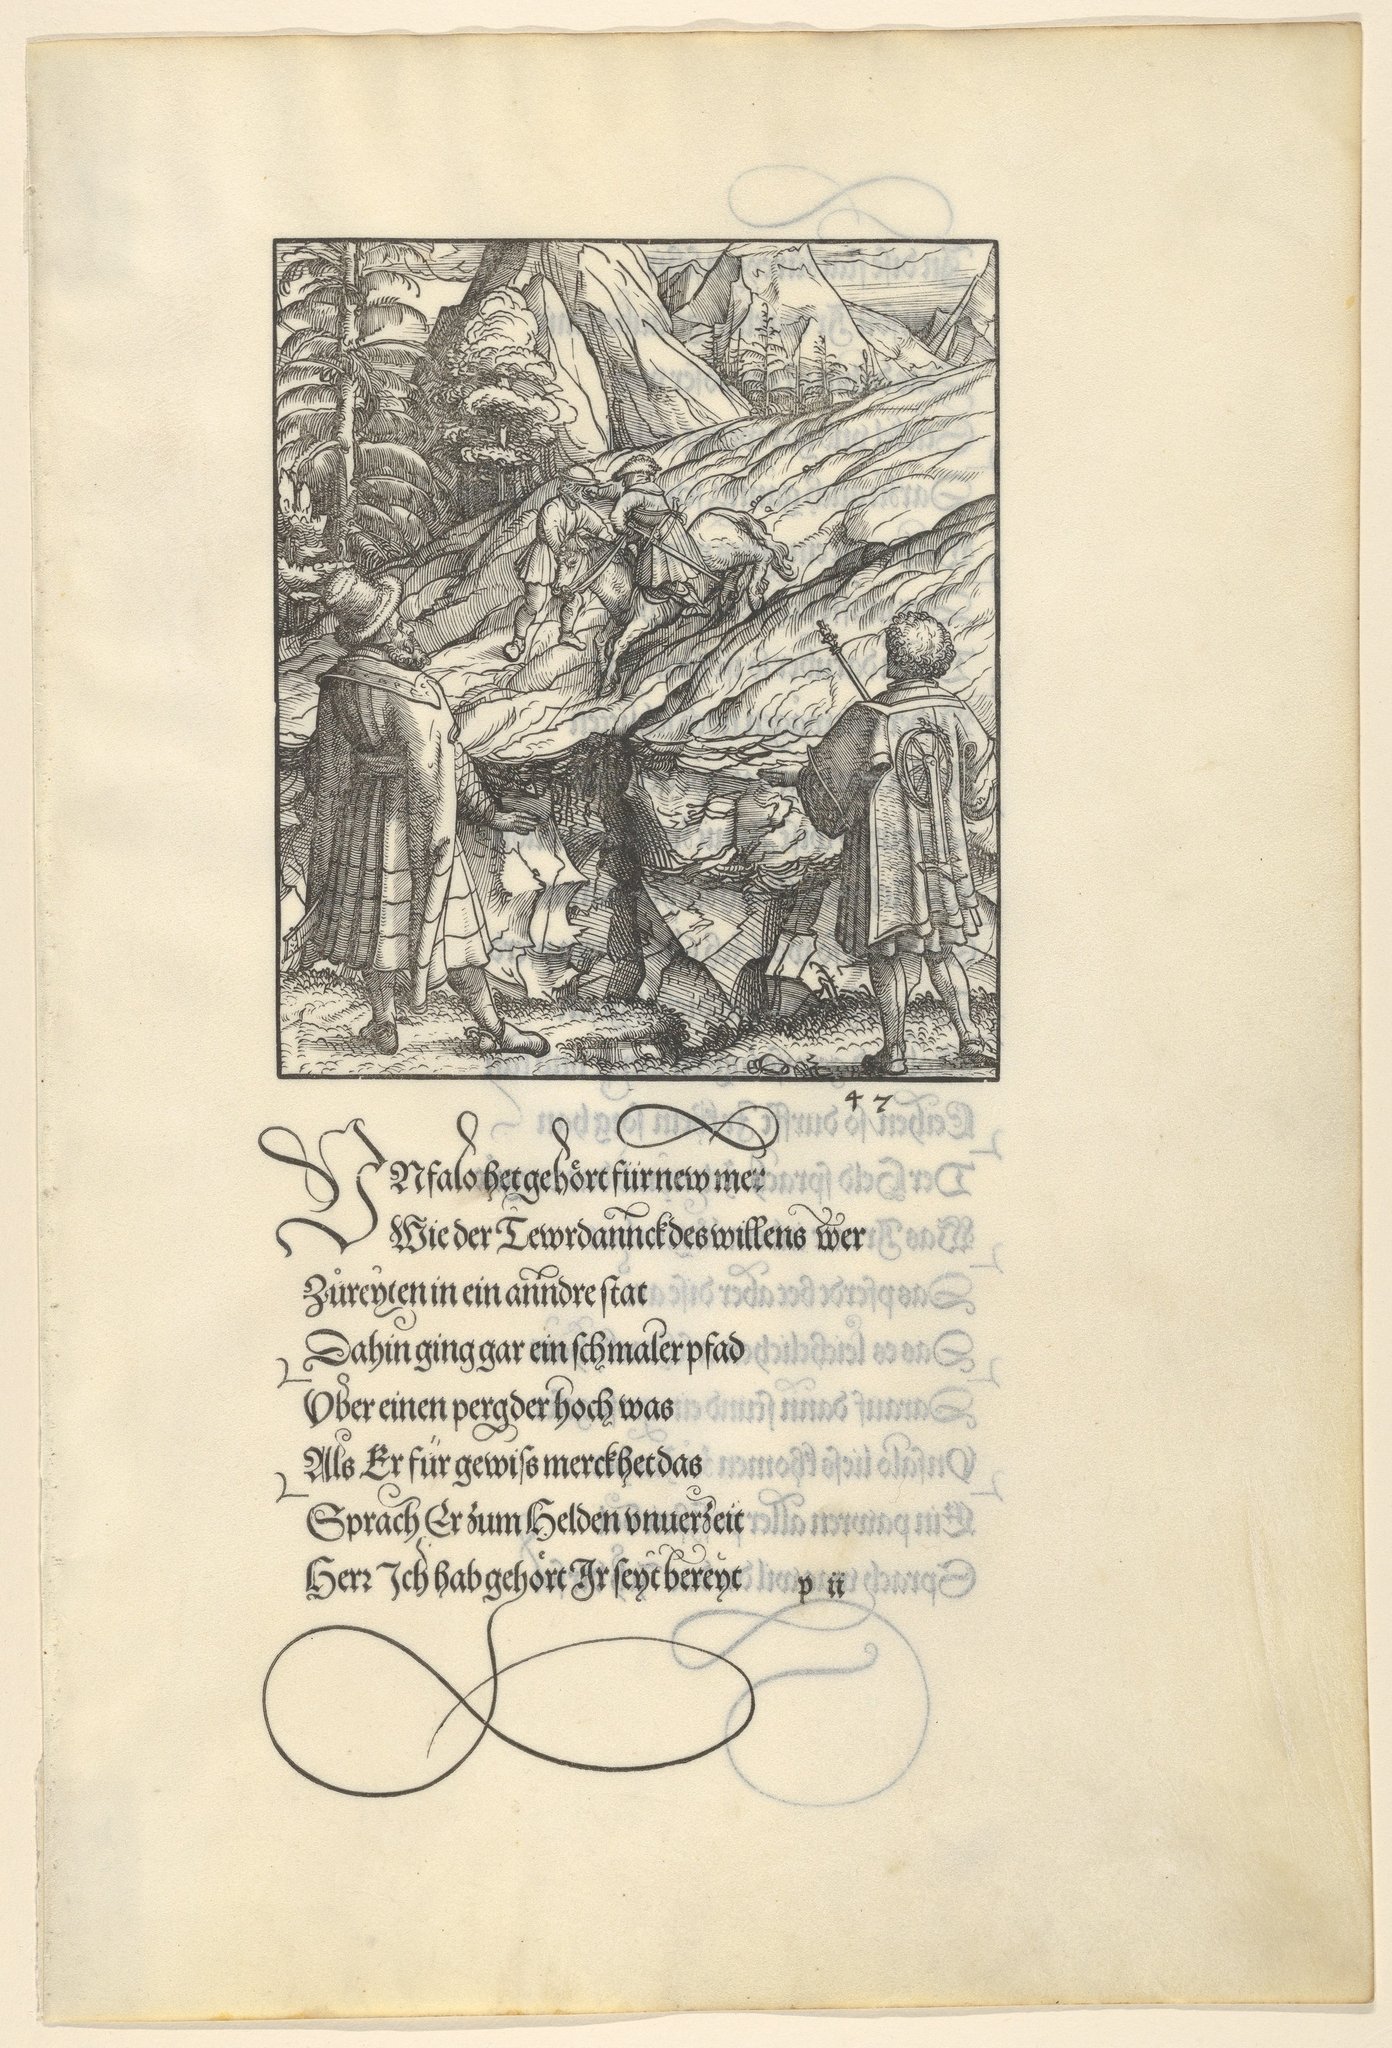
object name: print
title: Theuerdarnk's Horse Falls Under Him, from [Theuerdank] Die geuerlicheiten vnd einsteils der geschichten des loblichen streytparen vnd hochberümbten helds vnd Ritters herr Tewrdannckhs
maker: hans burgkmair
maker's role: artist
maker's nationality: german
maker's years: 1473-1531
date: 1517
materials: parchment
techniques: woodcut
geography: germany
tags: men,horses,knights